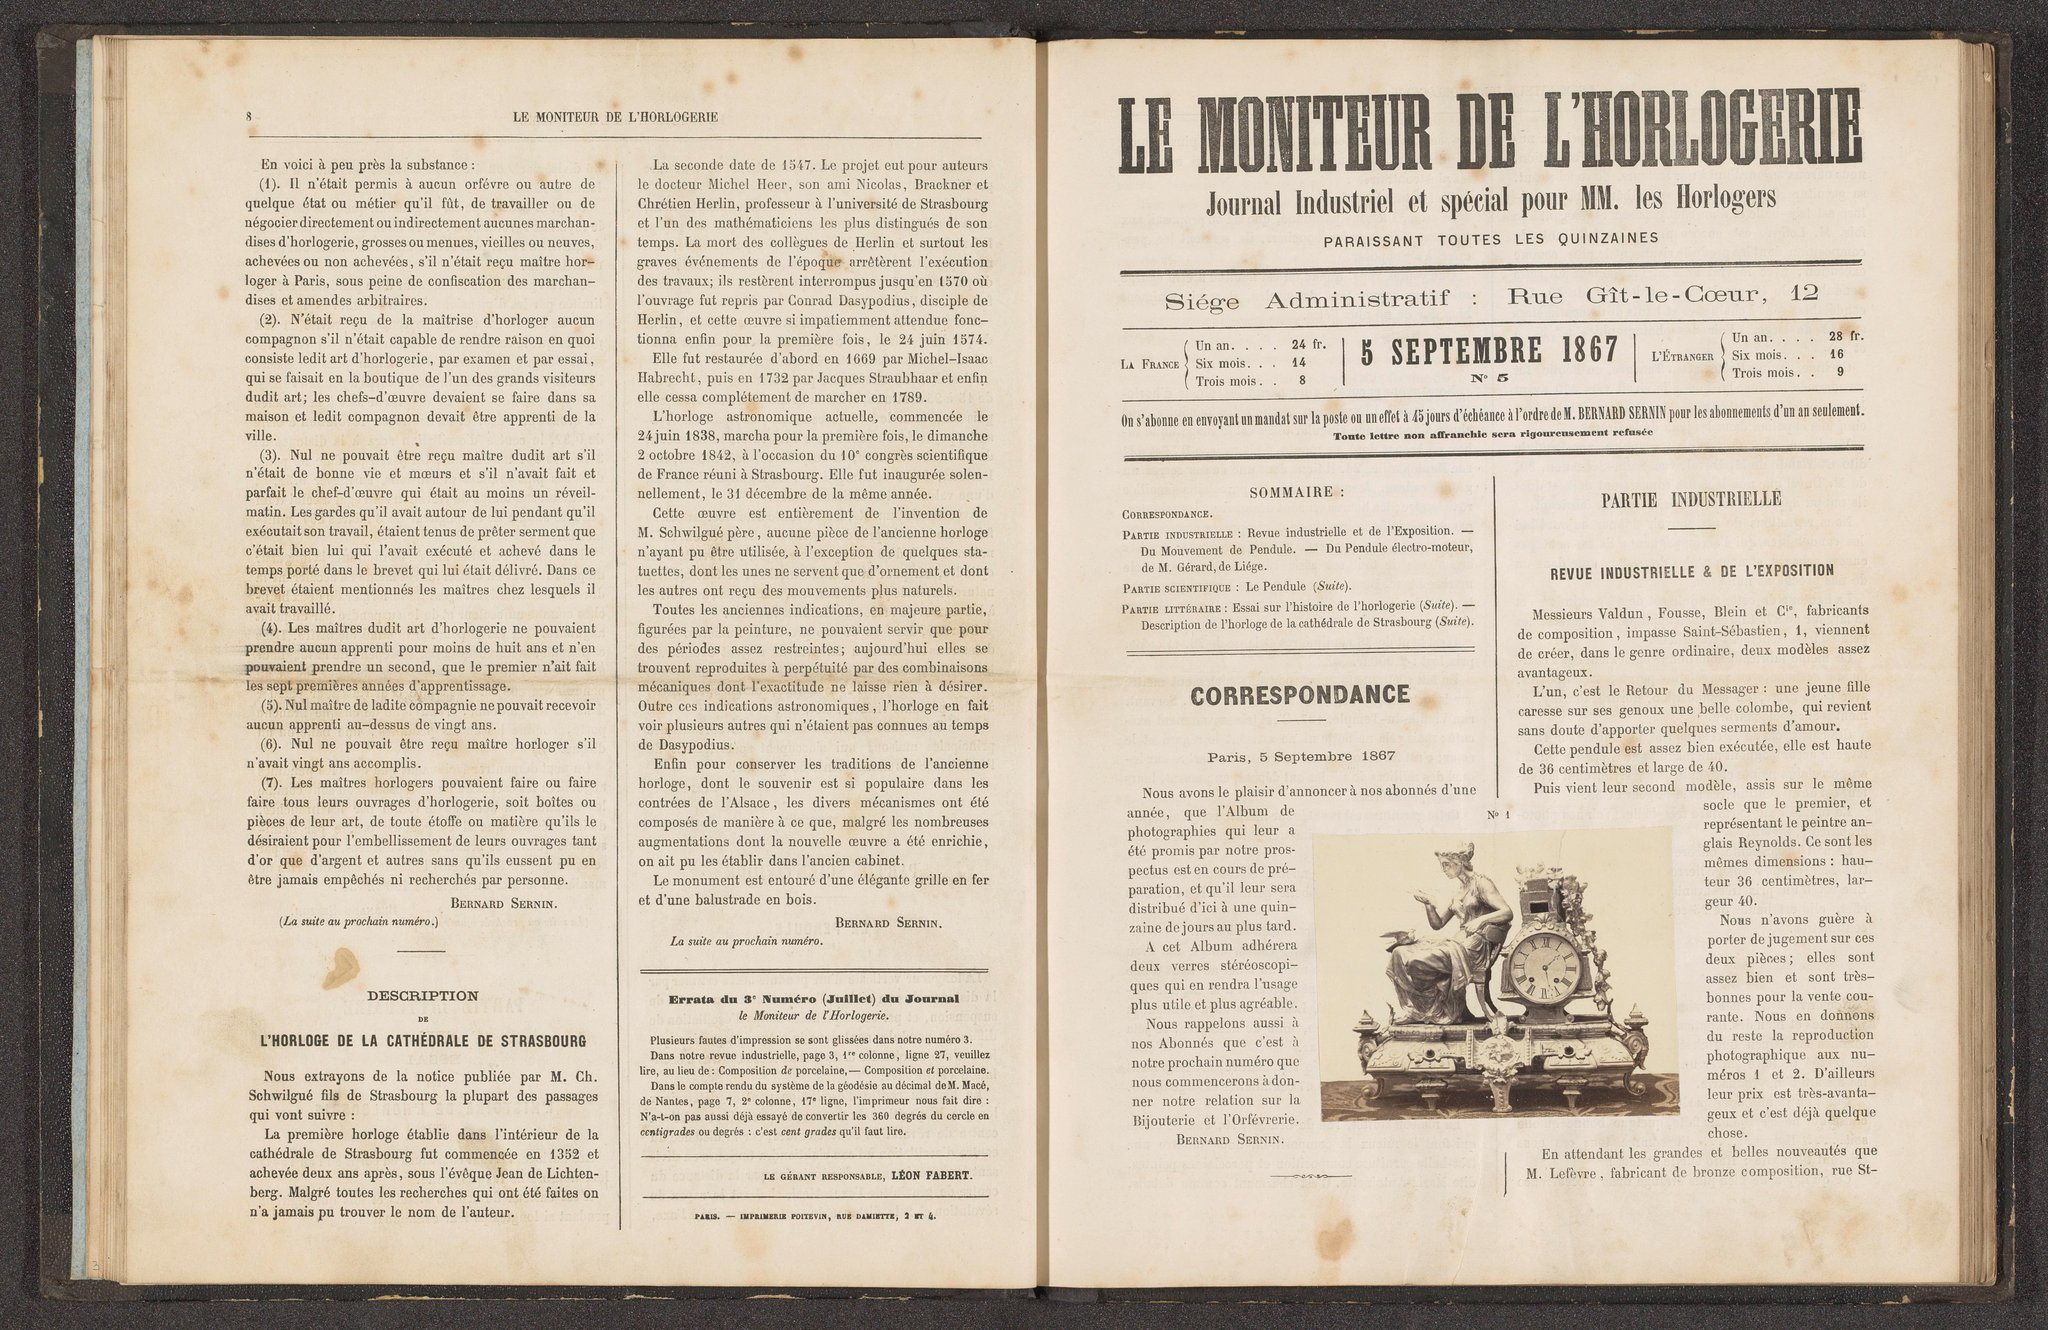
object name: photograph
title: Klok gedecoreerd met een zittende vrouw met een duif door Messieurs Valdun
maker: Anonymous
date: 1857-1867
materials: photographic support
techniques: albumen print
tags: clock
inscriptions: number: ‘No 1’